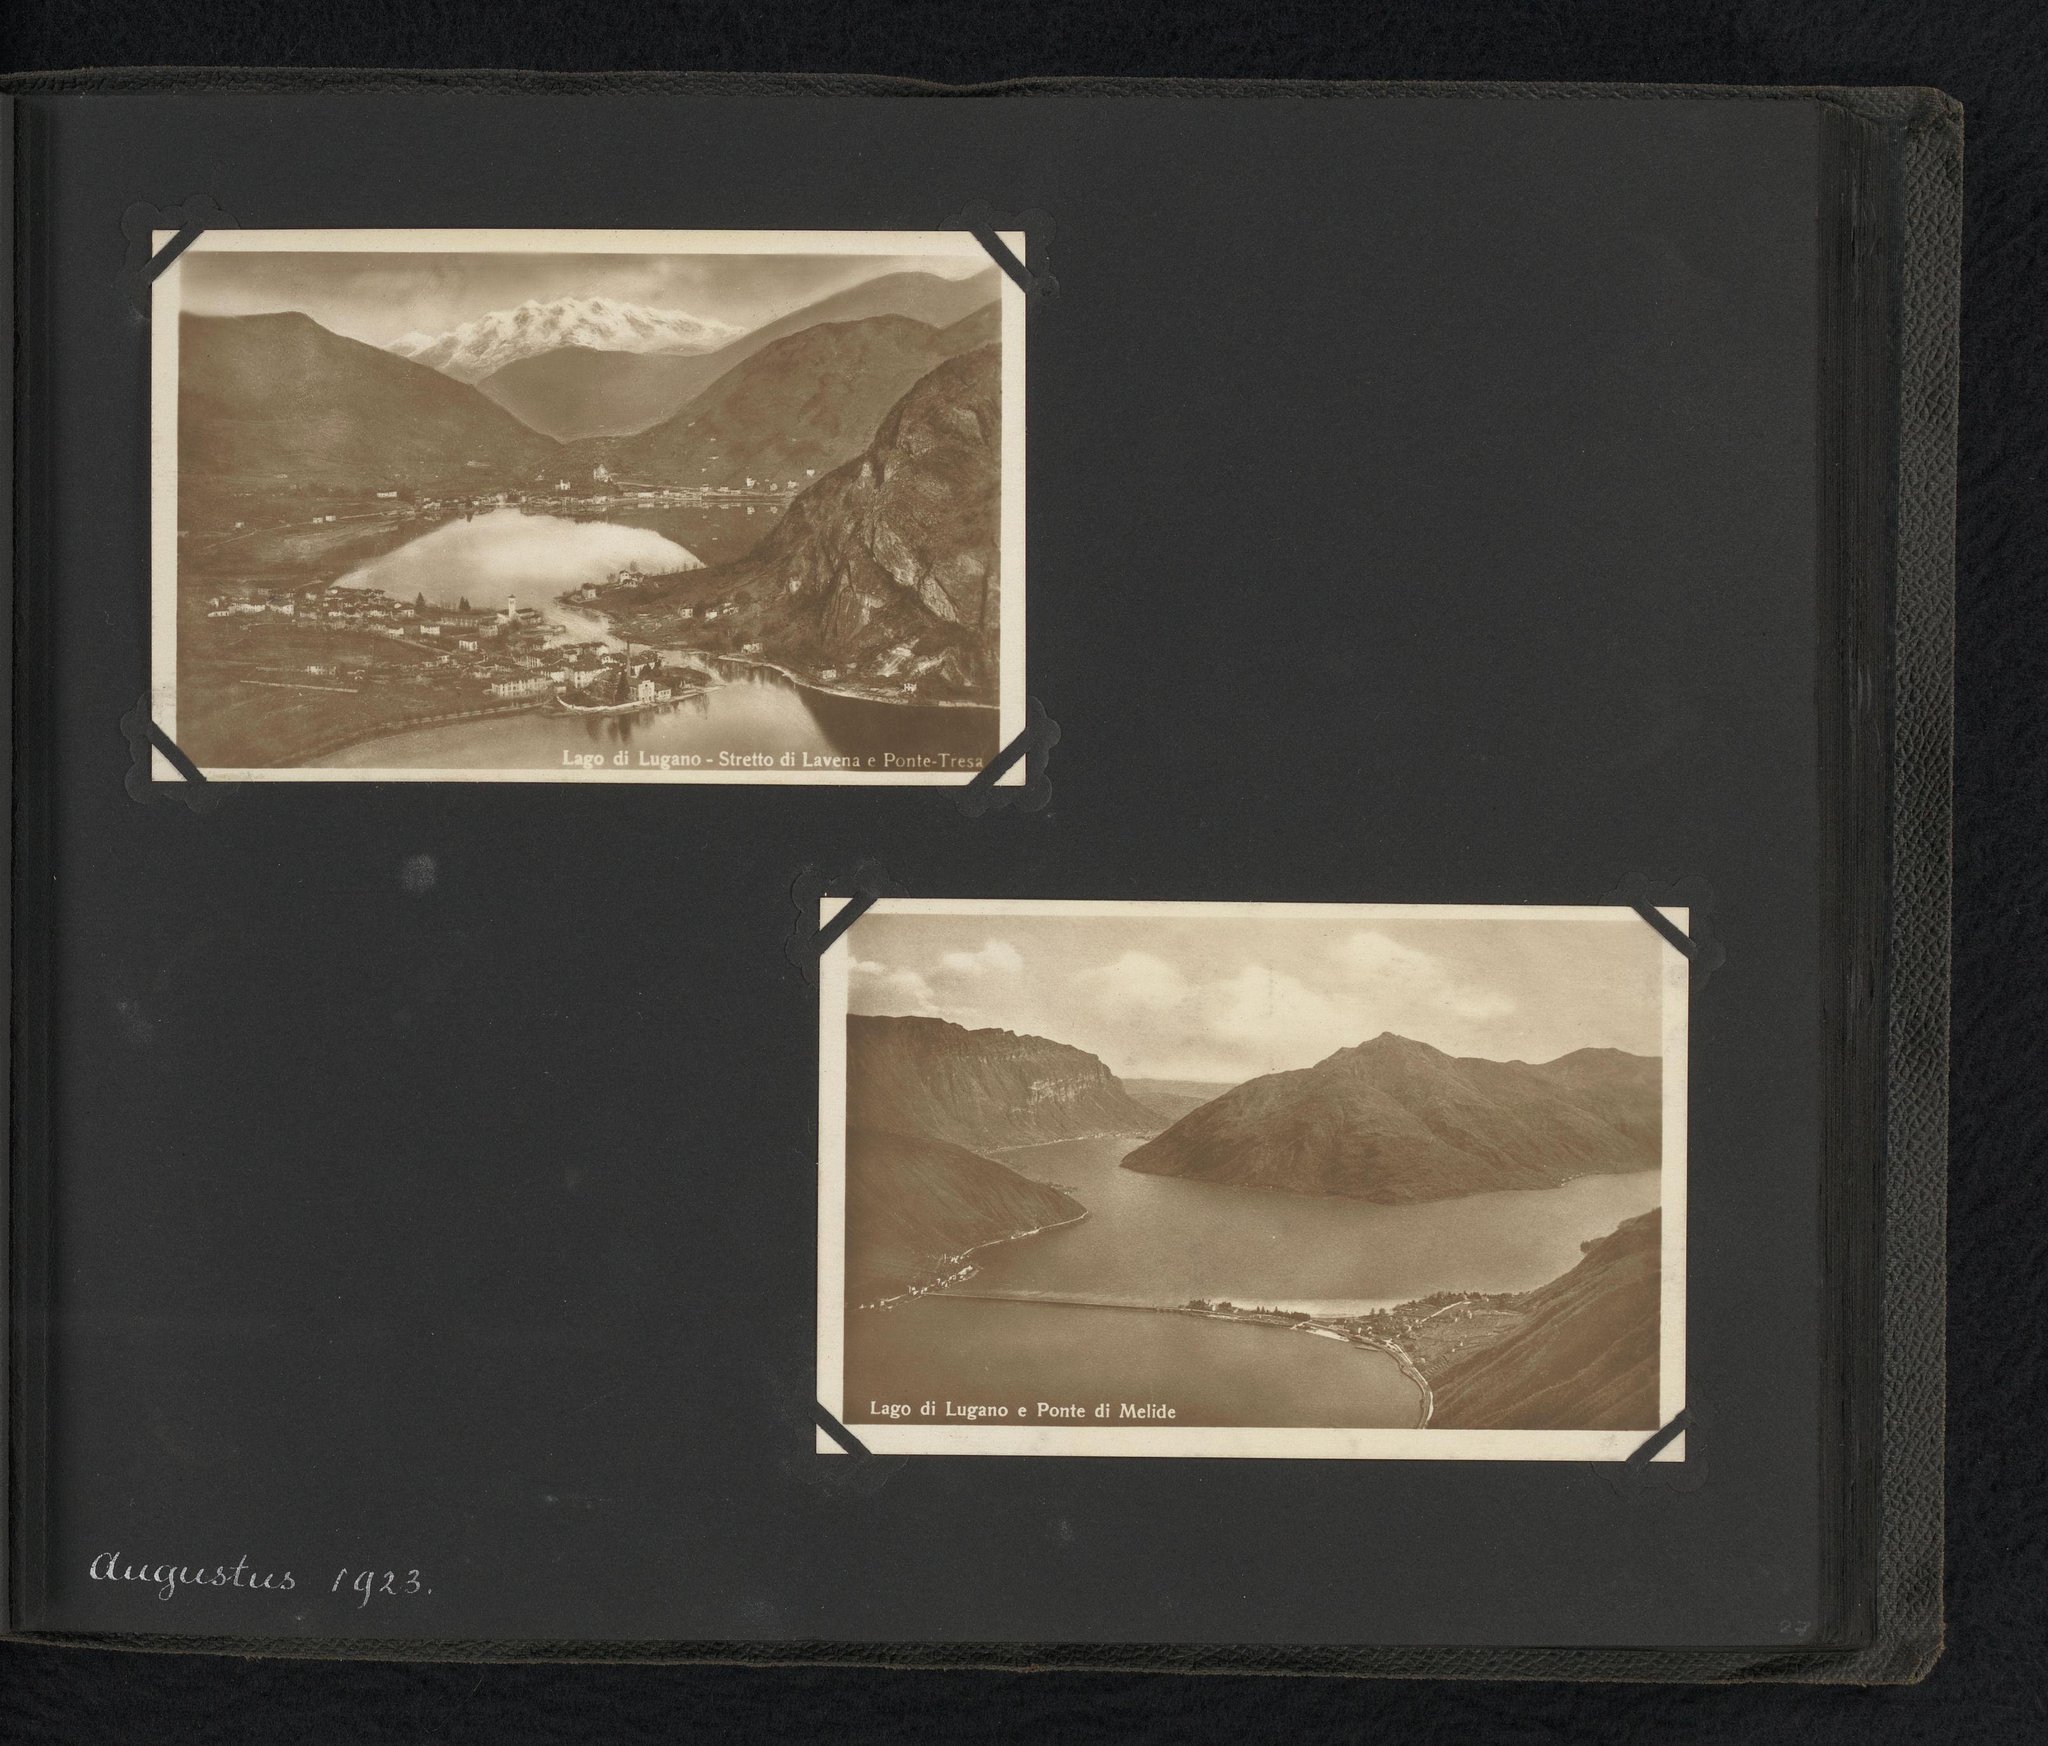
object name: album leaf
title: Twee fotografische prentbriefkaarten van het Meer van Lugano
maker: Anonymous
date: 1908-1923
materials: paper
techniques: gelatin silver print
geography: ticino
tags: lake, mountains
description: Deze foto's maken deel uit van een album.